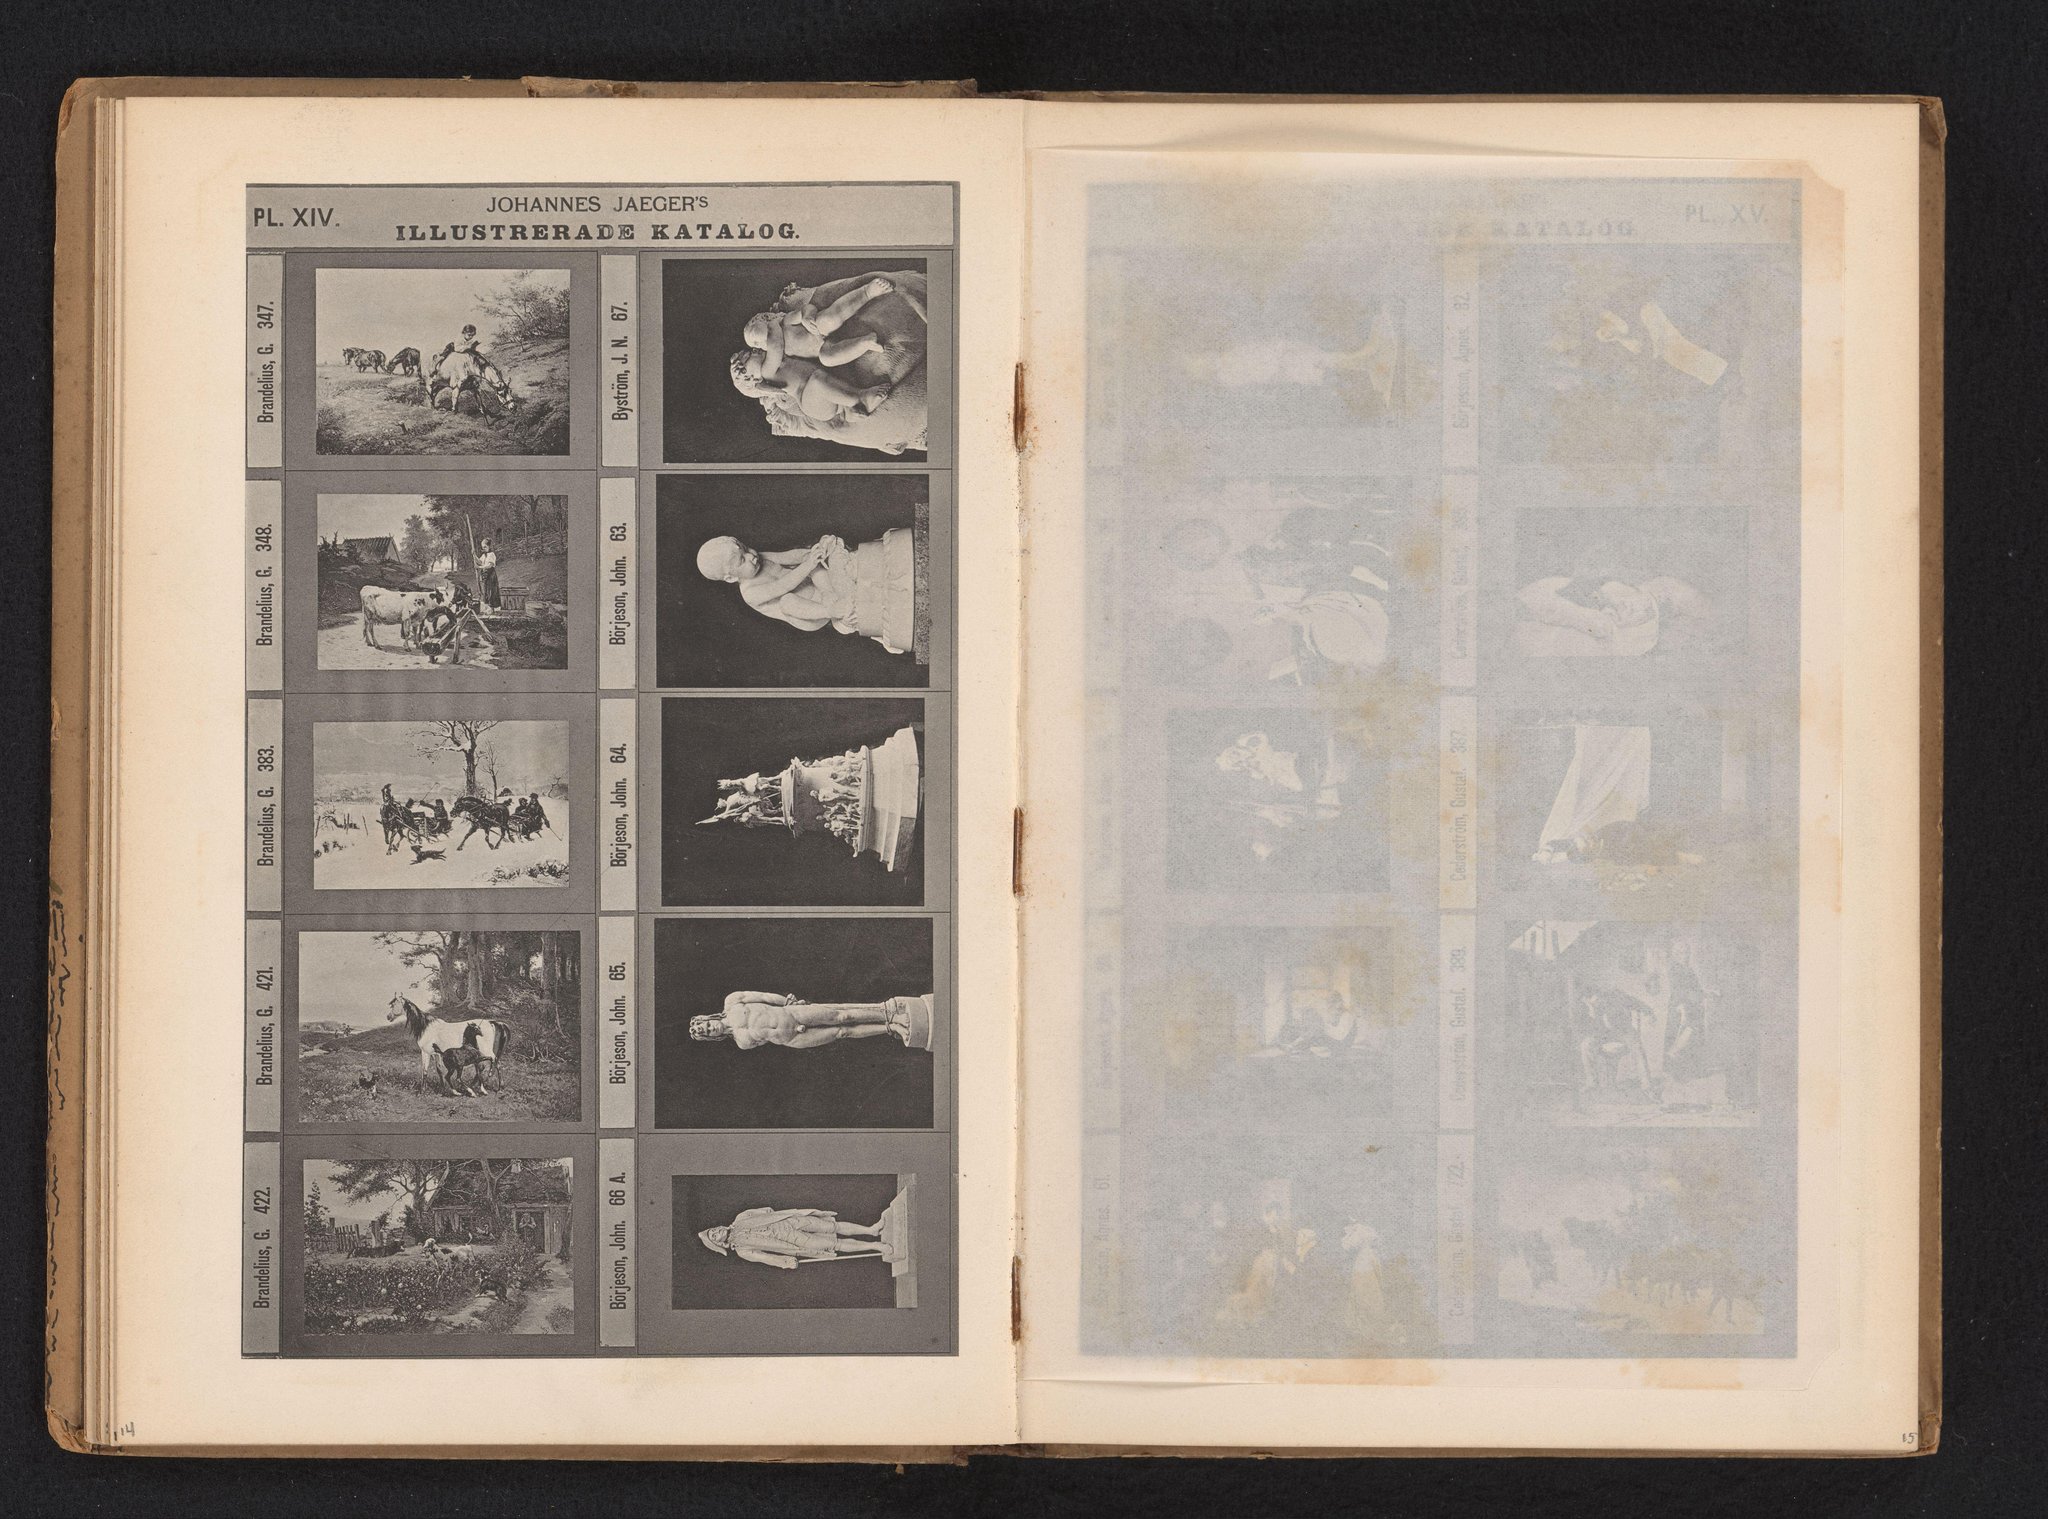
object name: photomechanical print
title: Fotoreproductie van vijf schilderijen met dieren en vijf sculpturen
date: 1872-1882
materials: paper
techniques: photograph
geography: stockholm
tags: sculpture, picture, painting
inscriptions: number: ‘PL. XIV.’